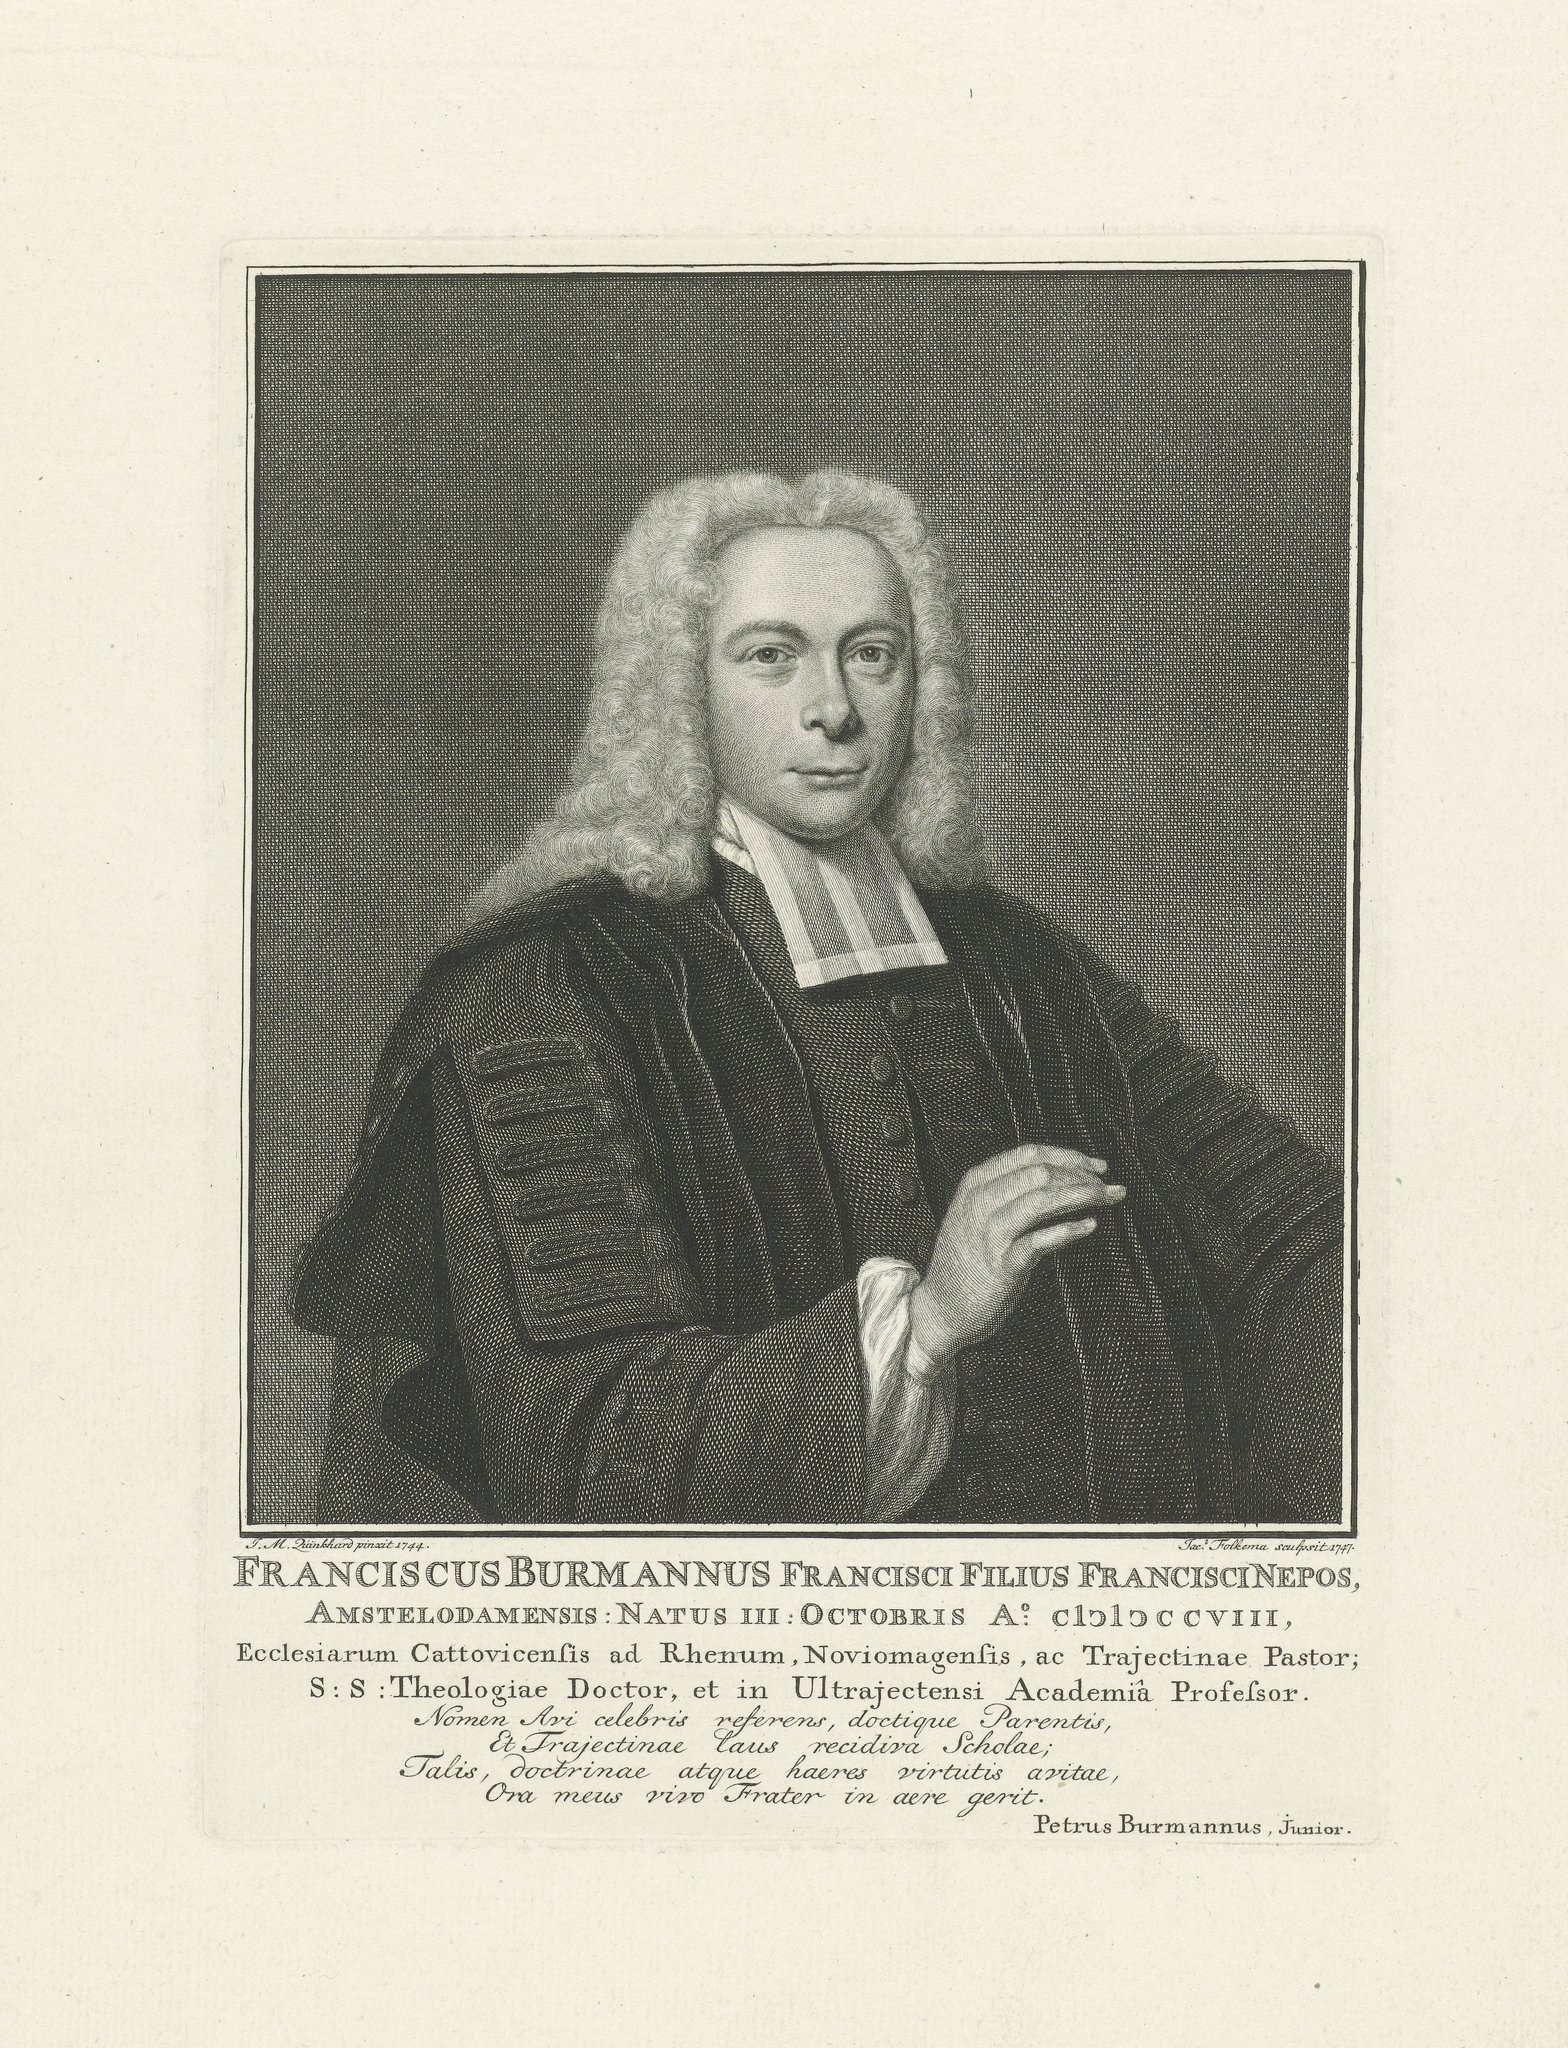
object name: print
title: Portret van Frans Burman (II)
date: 1747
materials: paper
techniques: engraving, etching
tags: amsterdam, utrecht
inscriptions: collector's mark: Lugt 2228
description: Portret ten halven lijve naar rechts van Franciscus Burmannus, professor in de theologie, blootshoofds. In de marge staan in het Latijn de naam, geboortegegevens en titels van de geportretteerde, gevolgd door een vierregelig vers.